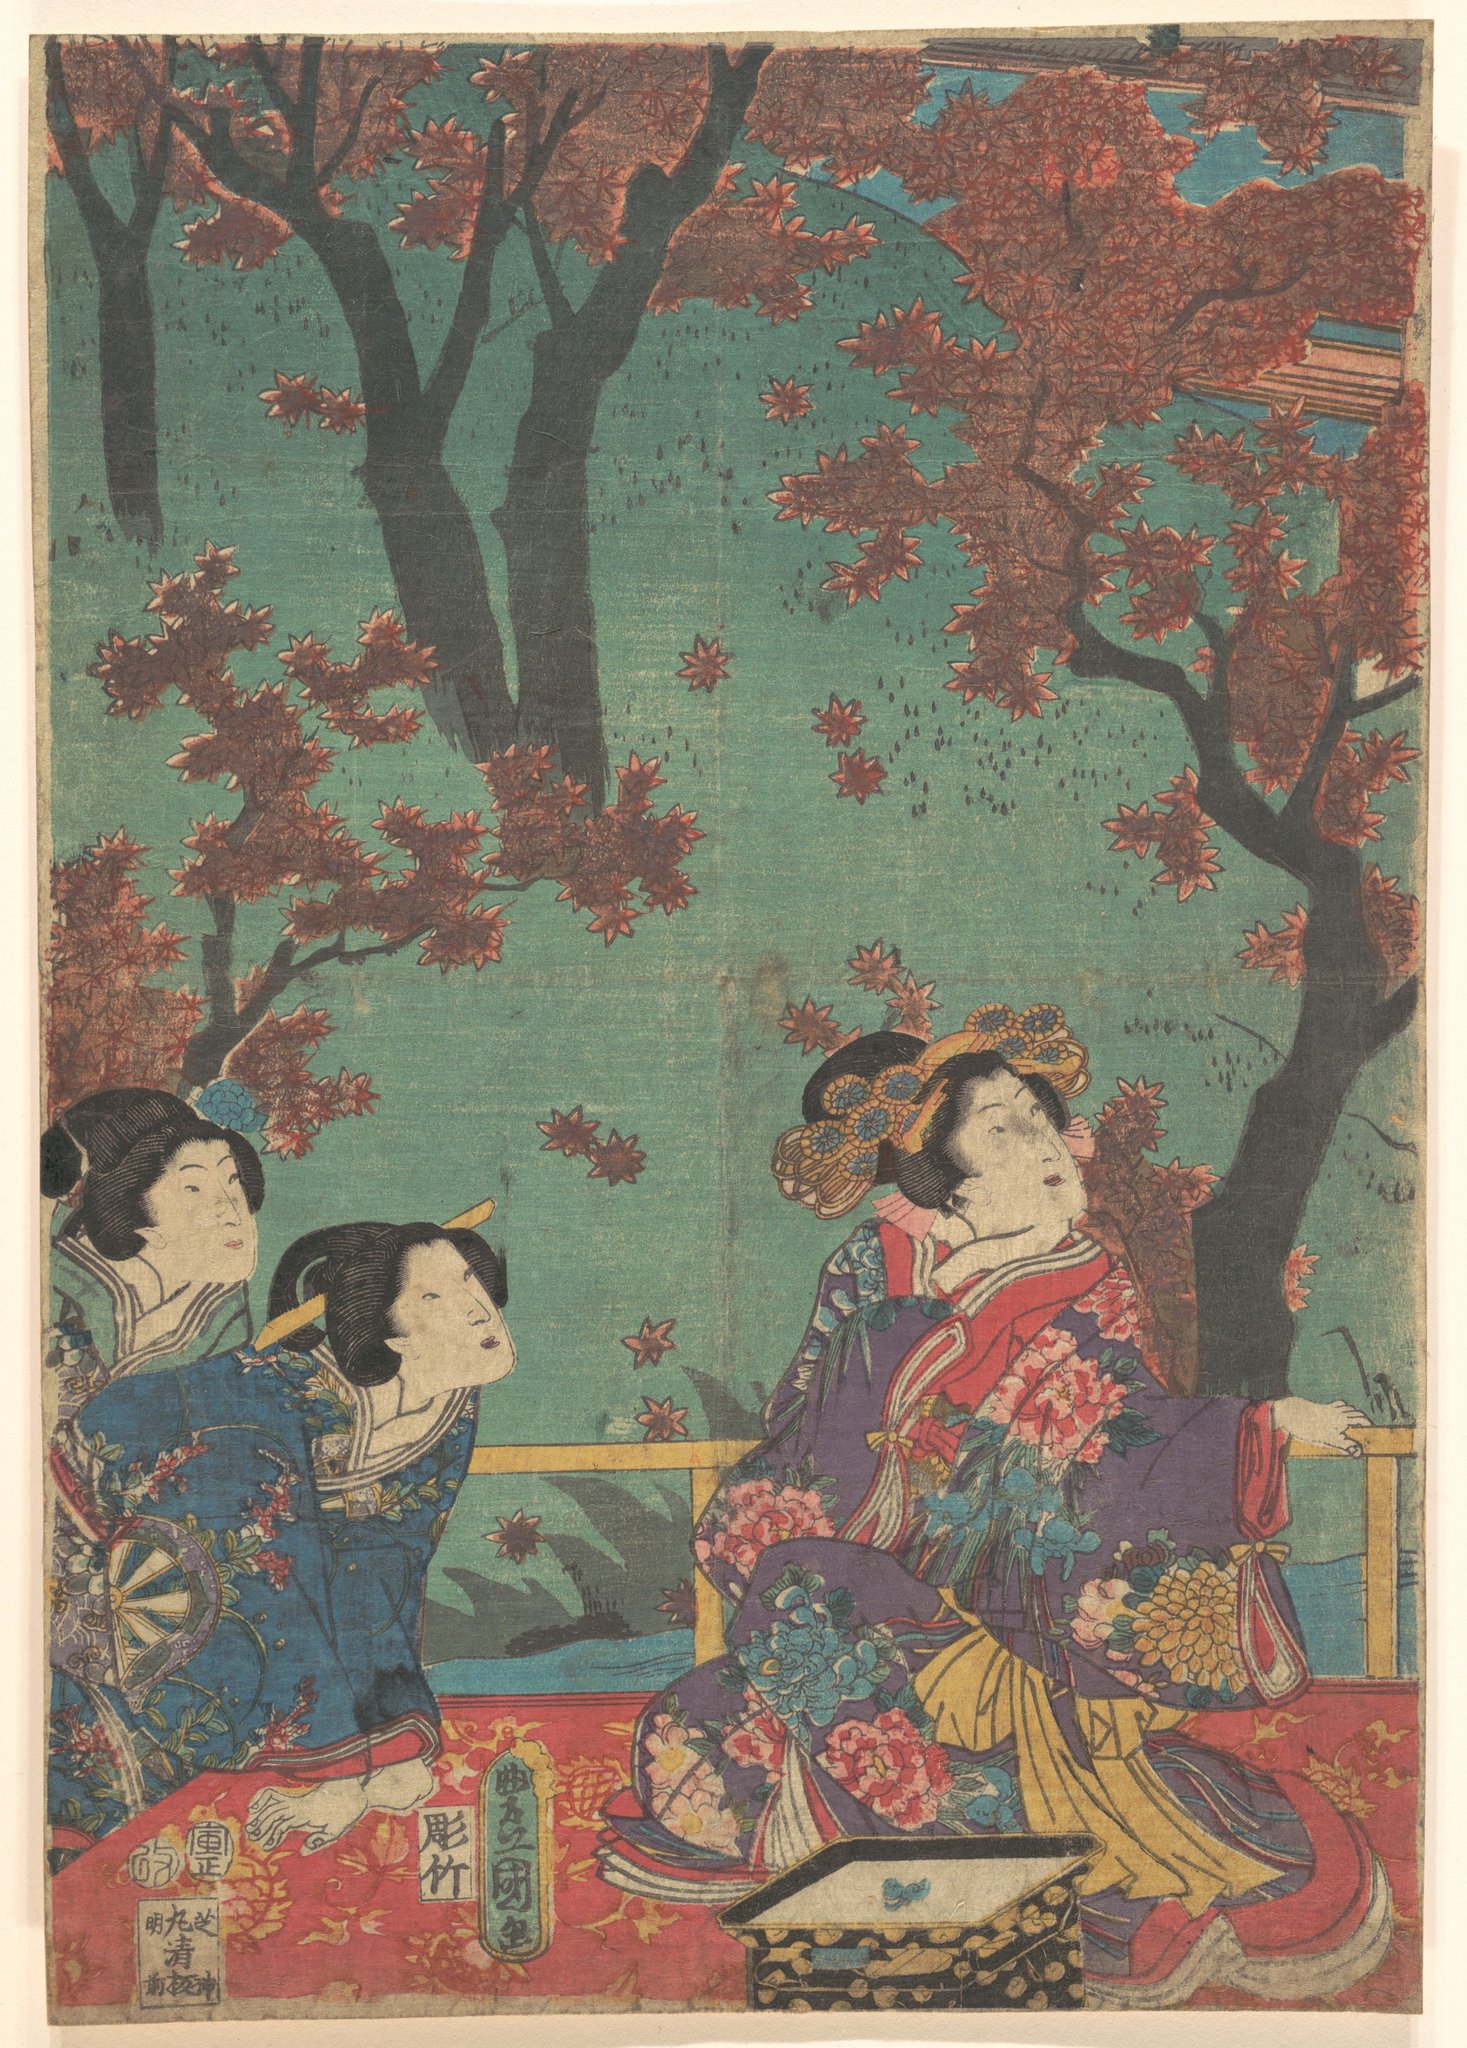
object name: print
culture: japanese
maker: utagawa kunisada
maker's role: artist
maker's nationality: japanese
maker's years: 1786-1864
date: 1786-1854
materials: ink, paper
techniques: woodblock print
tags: women,trees